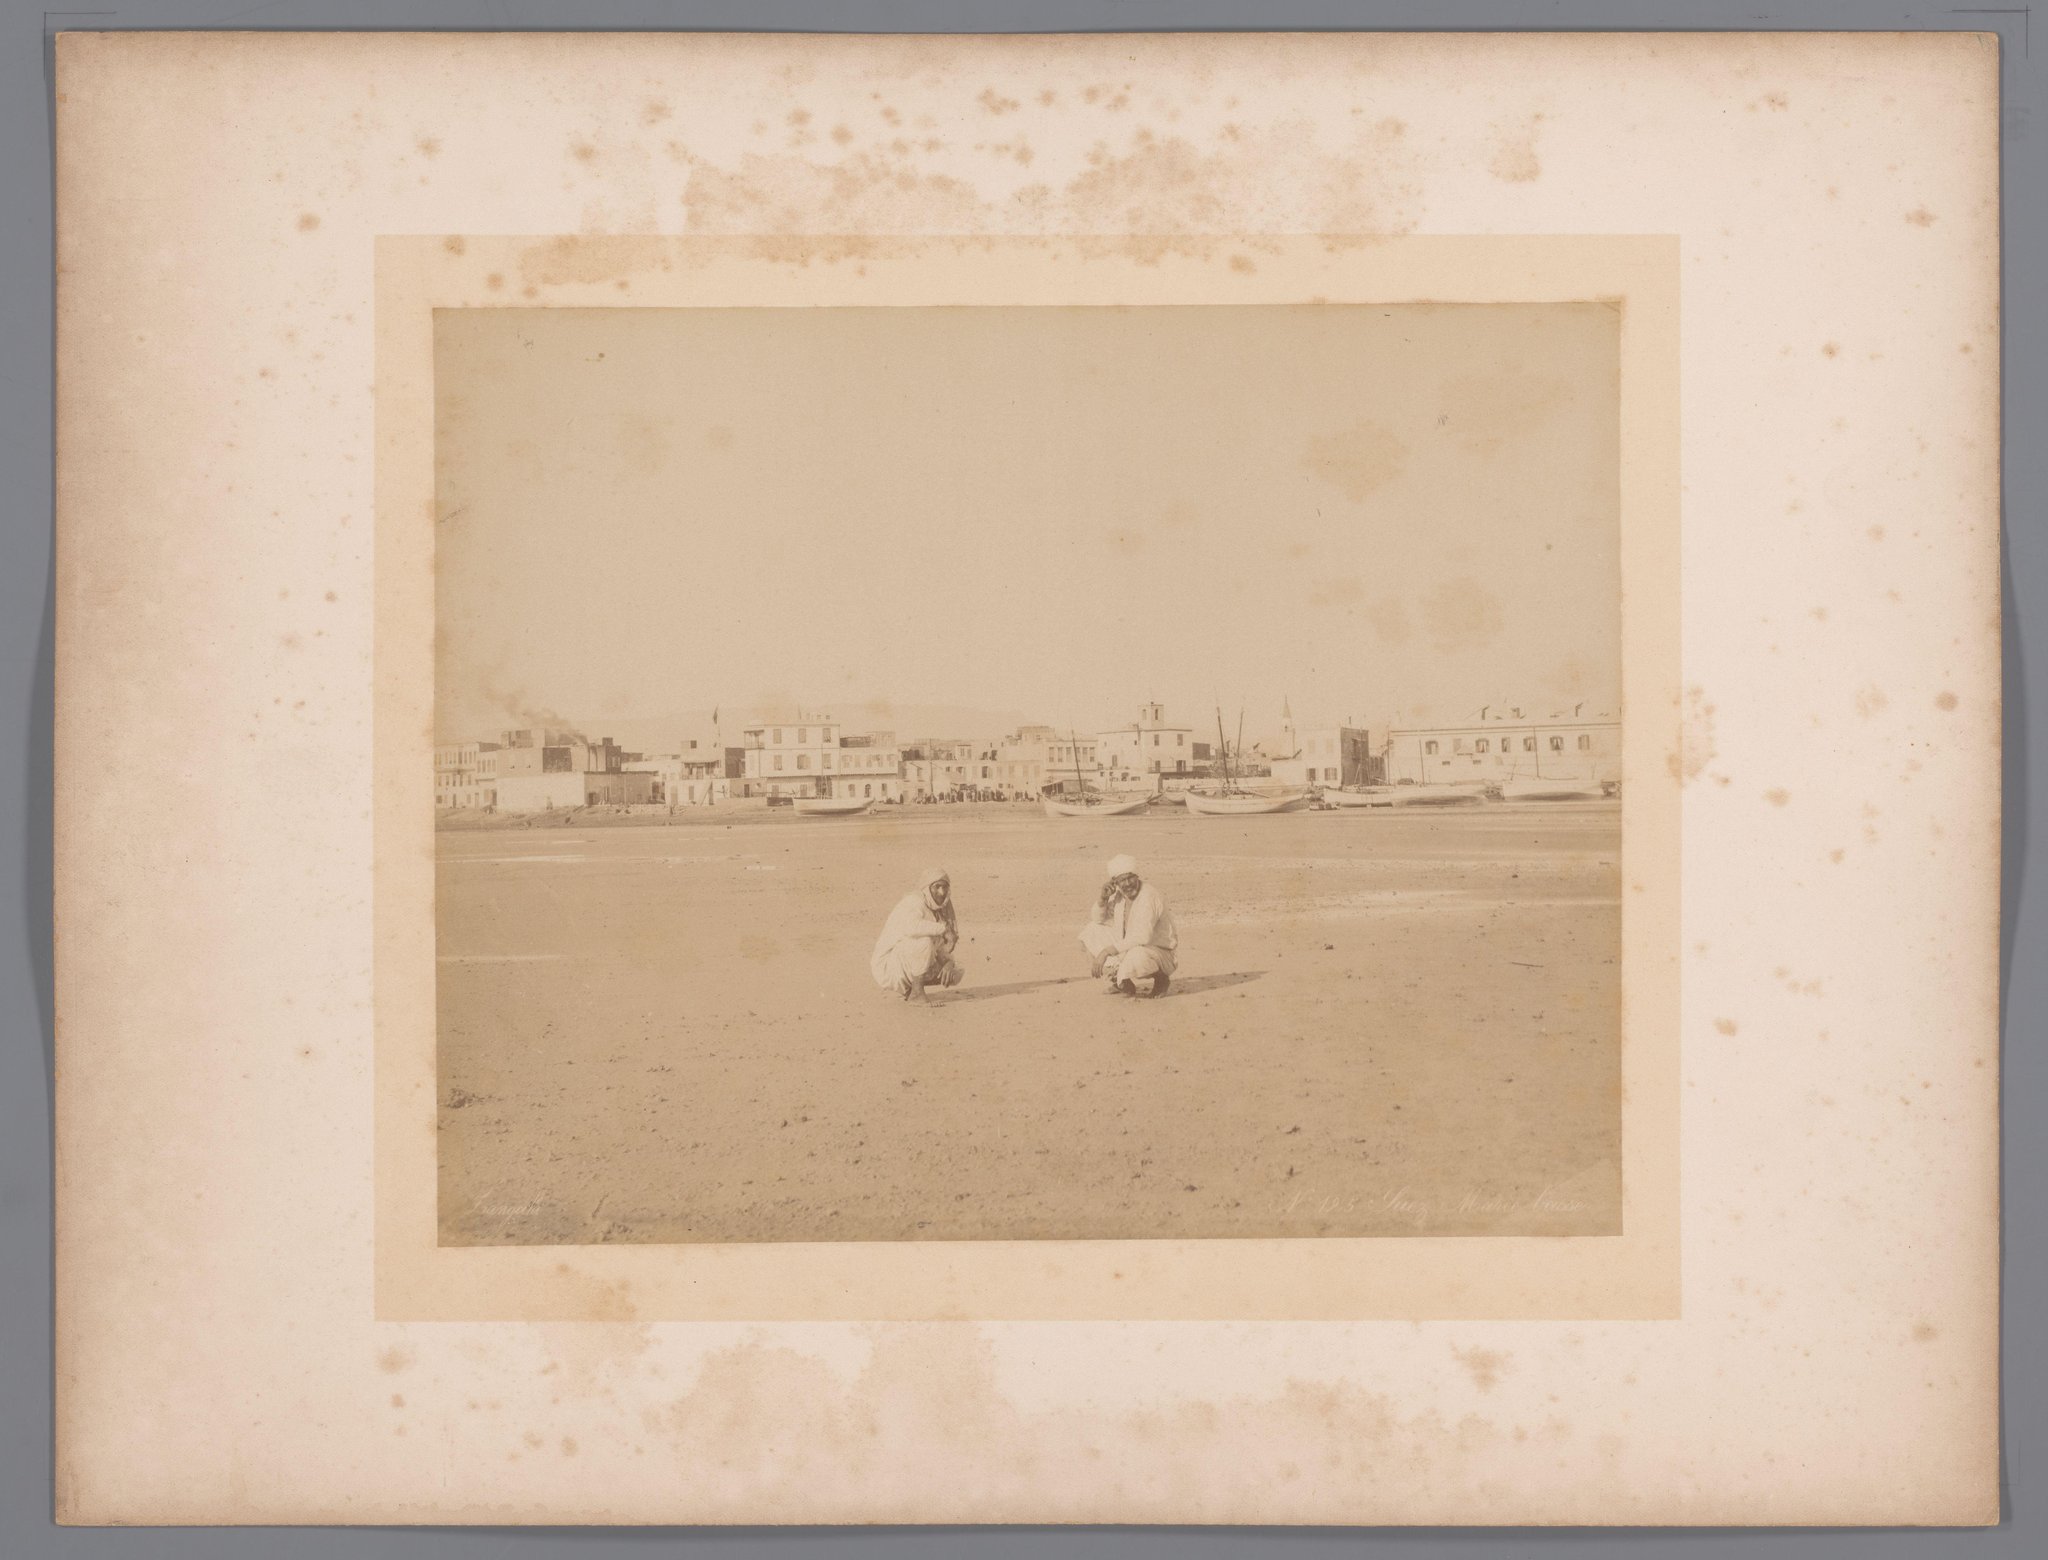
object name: photograph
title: Twee mannen in de haven van Suez bij eb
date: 1870-1910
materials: cardboard, paper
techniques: albumen print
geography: suez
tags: harbour, ebb, low tide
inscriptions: inscription: ‘foto Zangaki no 125/ Suez Marée basse’, number: ‘No. 125’